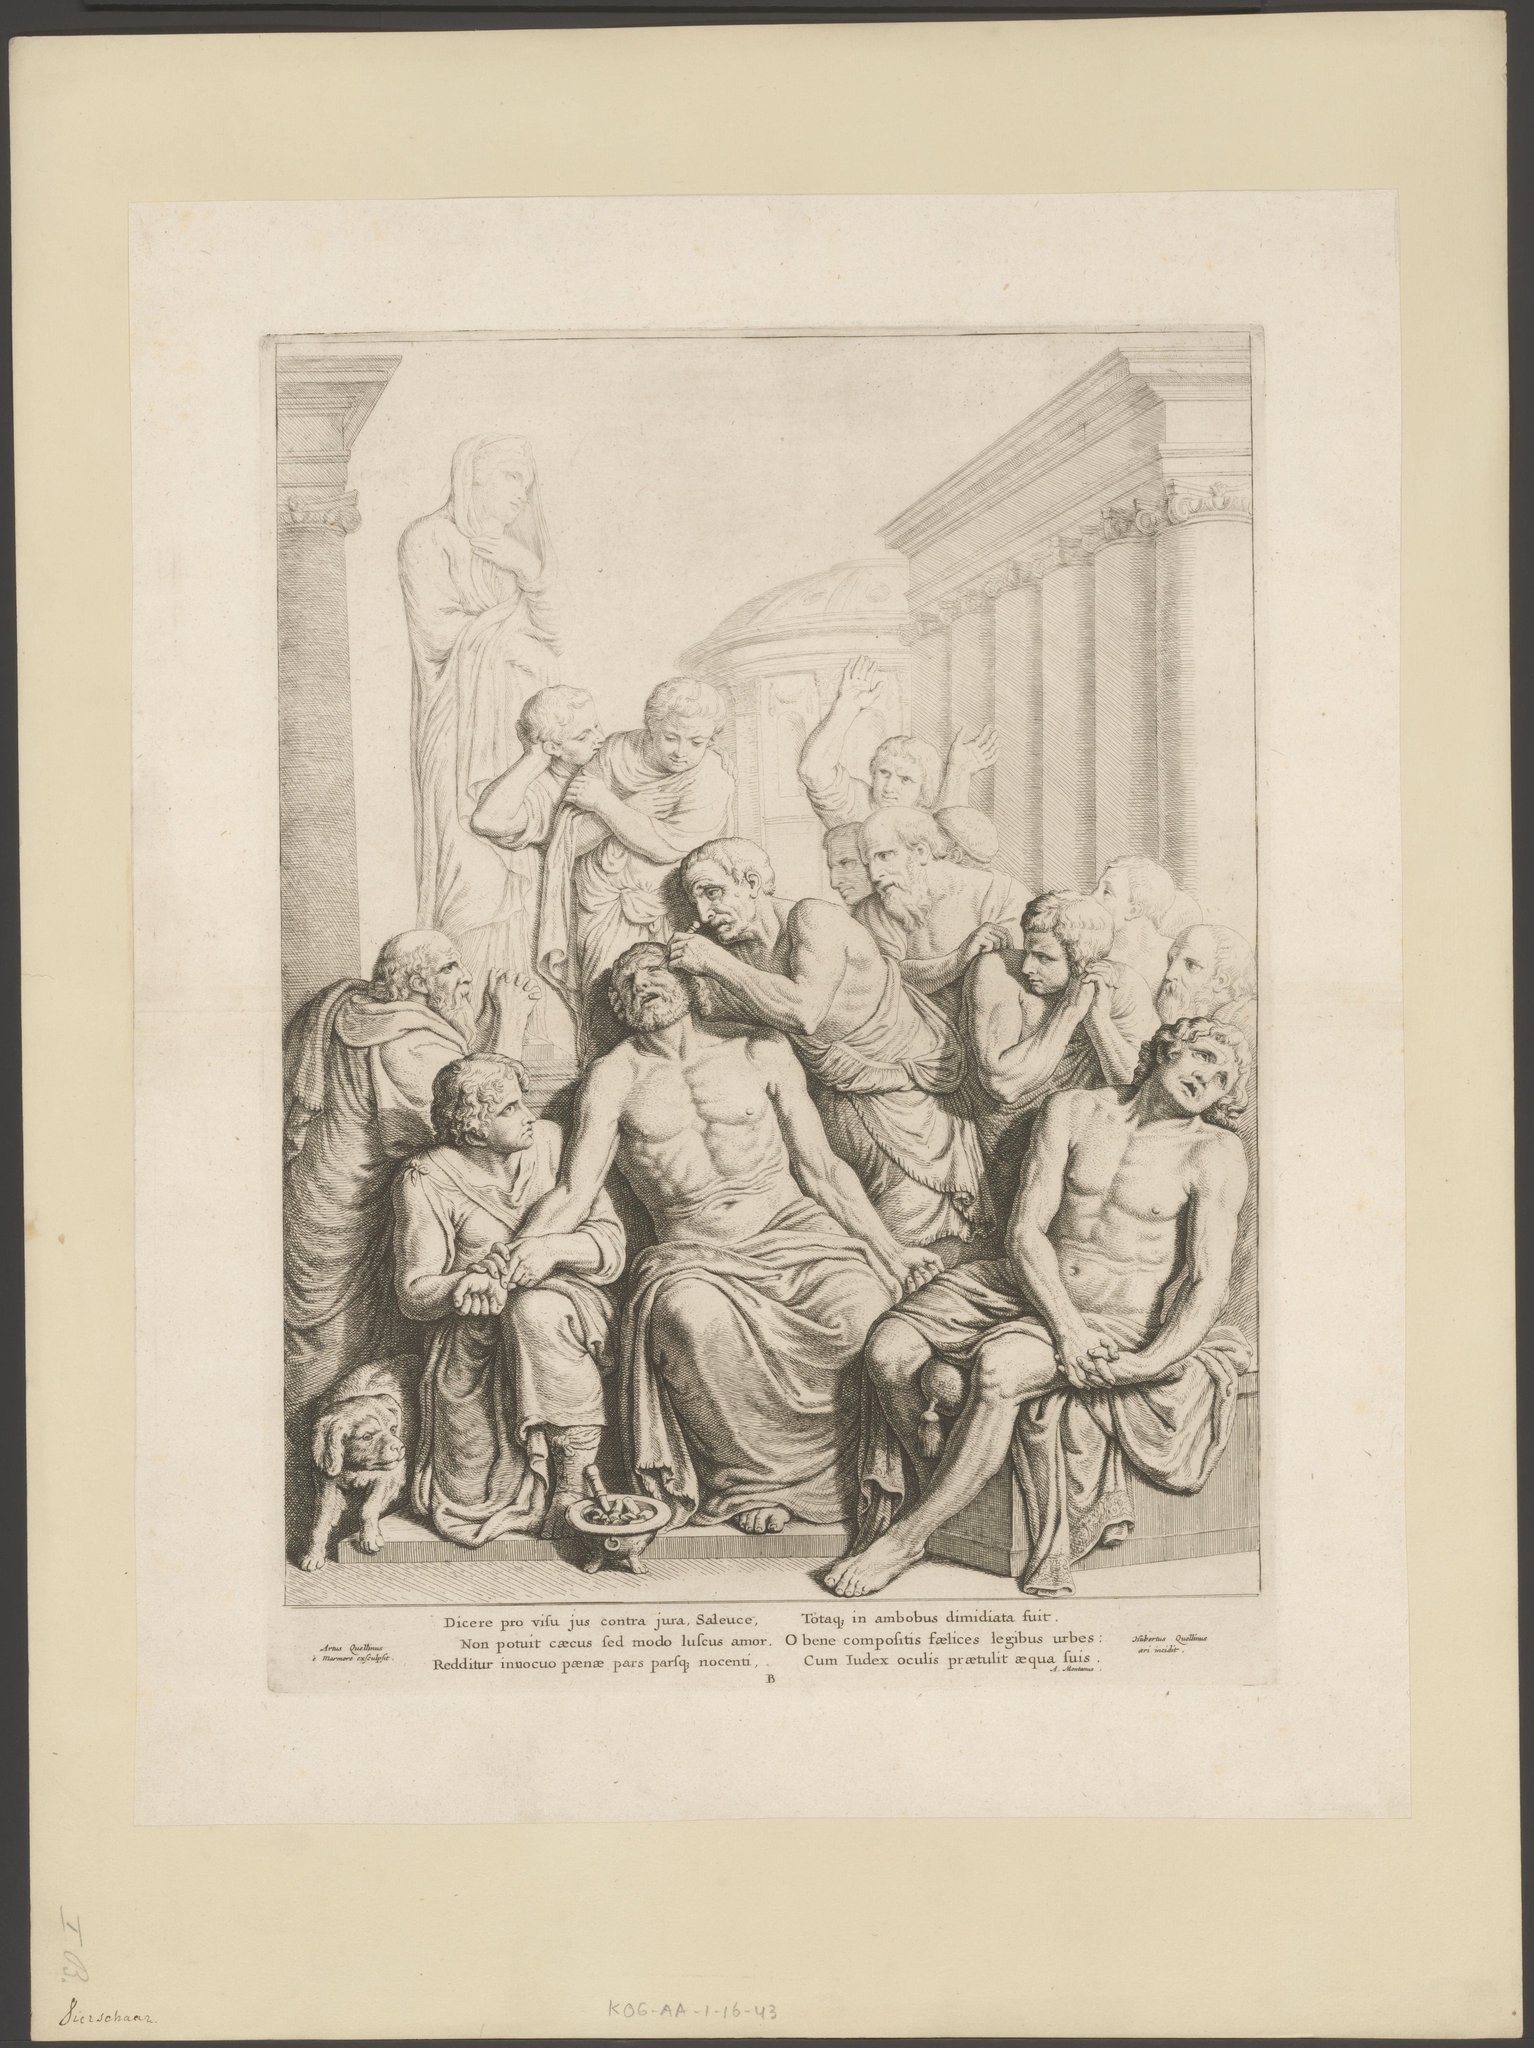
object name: print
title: Reliëf met het oordeel van Zaleucus in de Vierschaar van het Stadhuis op de Dam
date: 1655-1665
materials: paper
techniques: engraving, etching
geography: amsterdam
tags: the judgement of zaleucus: when zaleucus' son is sentenced to be blinded in both eyes, zaleucus has one of his son's eyes plucked out and one of his own, townhall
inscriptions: collector's mark: ‘16,43’ Lugt 1641b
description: Prent gebruikt in: Prima pars. Praecipuarum effigierum ac ornamentorum, amplissimae Curiae Amstelrodamensis (…) / Het eerste deel. Van de voornaemste Statuen ende Ciraten, vant konstijck Stadhuys van Amstelredam, tmeeste in marmer gemaeckt, door Artus Quellinus, Beelthouwer der voorseyde Stadt / La Premier Partie. De plusieurs Figures et ornements, de la Maison de Ville d'Amsterdam (…). Amsterdam: Artus Quellinus (I), 1655. Zie RP-P-AO-22-1-1 voor bijhorende titelpagina. Zie RP-P-AO-22-1-2 voor bijhorend register. Zie RP-P-AO-22-1A, RP-P-AO-22-1C, RP-P-AO-22-1D-1, RP-P-AO-22-1D-2, RP-P-AO-22-1E, RP-P-AO-22-1F, RP-P-AO-22-1G, RP-P-AO-22-1H, RP-P-AO-22-1I, RP-P-AO-22-1K-1, RP-P-AO-22-1K-2, RP-P-AO-22-1K-3, RP-P-AO-22-1K-4, RP-P-AO-22-1K-5, RP-P-AO-22-1L-1, RP-P-AO-22-1L-2, RP-P-AO-22-1M-1, RP-P-AO-22-1M-2, RP-P-AO-22-1N-1, RP-P-AO-22-1N-2, RP-P-AO-22-1N-3, RP-P-AO-22-1N-4, RP-P-AO-22-1N-5, RP-P-AO-22-1O-1, RP-P-AO-22-1O-2, RP-P-AO-22-1O-3, RP-P-AO-22-1O-4, RP-P-AO-22-1P-1, RP-P-AO-22-1P-2, RP-P-AO-22-1P-3, RP-P-AO-22-1P-4, RP-P-AO-22-1Q-1, RP-P-AO-22-1Q-2, RP-P-AO-22-1Q-3, RP-P-AO-22-1Q-4, RP-P-AO-22-1R-1, RP-P-AO-22-1R-2, RP-P-AO-22-1R-3, RP-P-AO-22-1R-4, RP-P-AO-22-1R-5, RP-P-AO-22-1S-1, RP-P-AO-22-1S-2, RP-P-AO-22-1S-3, RP-P-AO-22-1S-4, RP-P-AO-22-1S-5, RP-P-AO-22-1T-1 en RP-P-AO-22-1T-2 voor andere prenten uit deze publicatie. Zelfde staat van prent ook gebruikt in: Prima pars. Praecipuarum effigierum ac ornamentorum, amplissimae Curiae Amstelrodamensis (…) / Het eerste deel. Van de voornaemste Statuen ende Ciraten, vant konstijck Stadhuys van Amstelredam, tmeeste in marmer gemaeckt, door Artus Quellinus, Beelthouwer der voorseyde Stadt / La Premier Partie. De plusieurs Figures et ornements, de la Maison de Ville d'Amsterdam (…). Amsterdam: Frederik de Wit, 1665. Latere staat van prent ook gebruikt in: Architecture peinture et sculpture de la Maison de Ville d'Amsterdam, representee en CIX. figures en taille-douce (…). Amsterdam: David Mortier, 1719. En in: Architecture peinture et sculpture de la Maison de Ville d'Amsterdam, representee en CIX. figures en taille-douce (…). Amsterdam: Gerard Valck, 1719. En in: Bouw schilder en beeldhouwkonst, van het Stadhuis te Amsteldam, vertoont in CIX figuuren (…). Amsterdam: Covens & Mortier & Covens Jr., s.a. (1774-1783). Zie BK-AM-51-23 voor model van beeld.